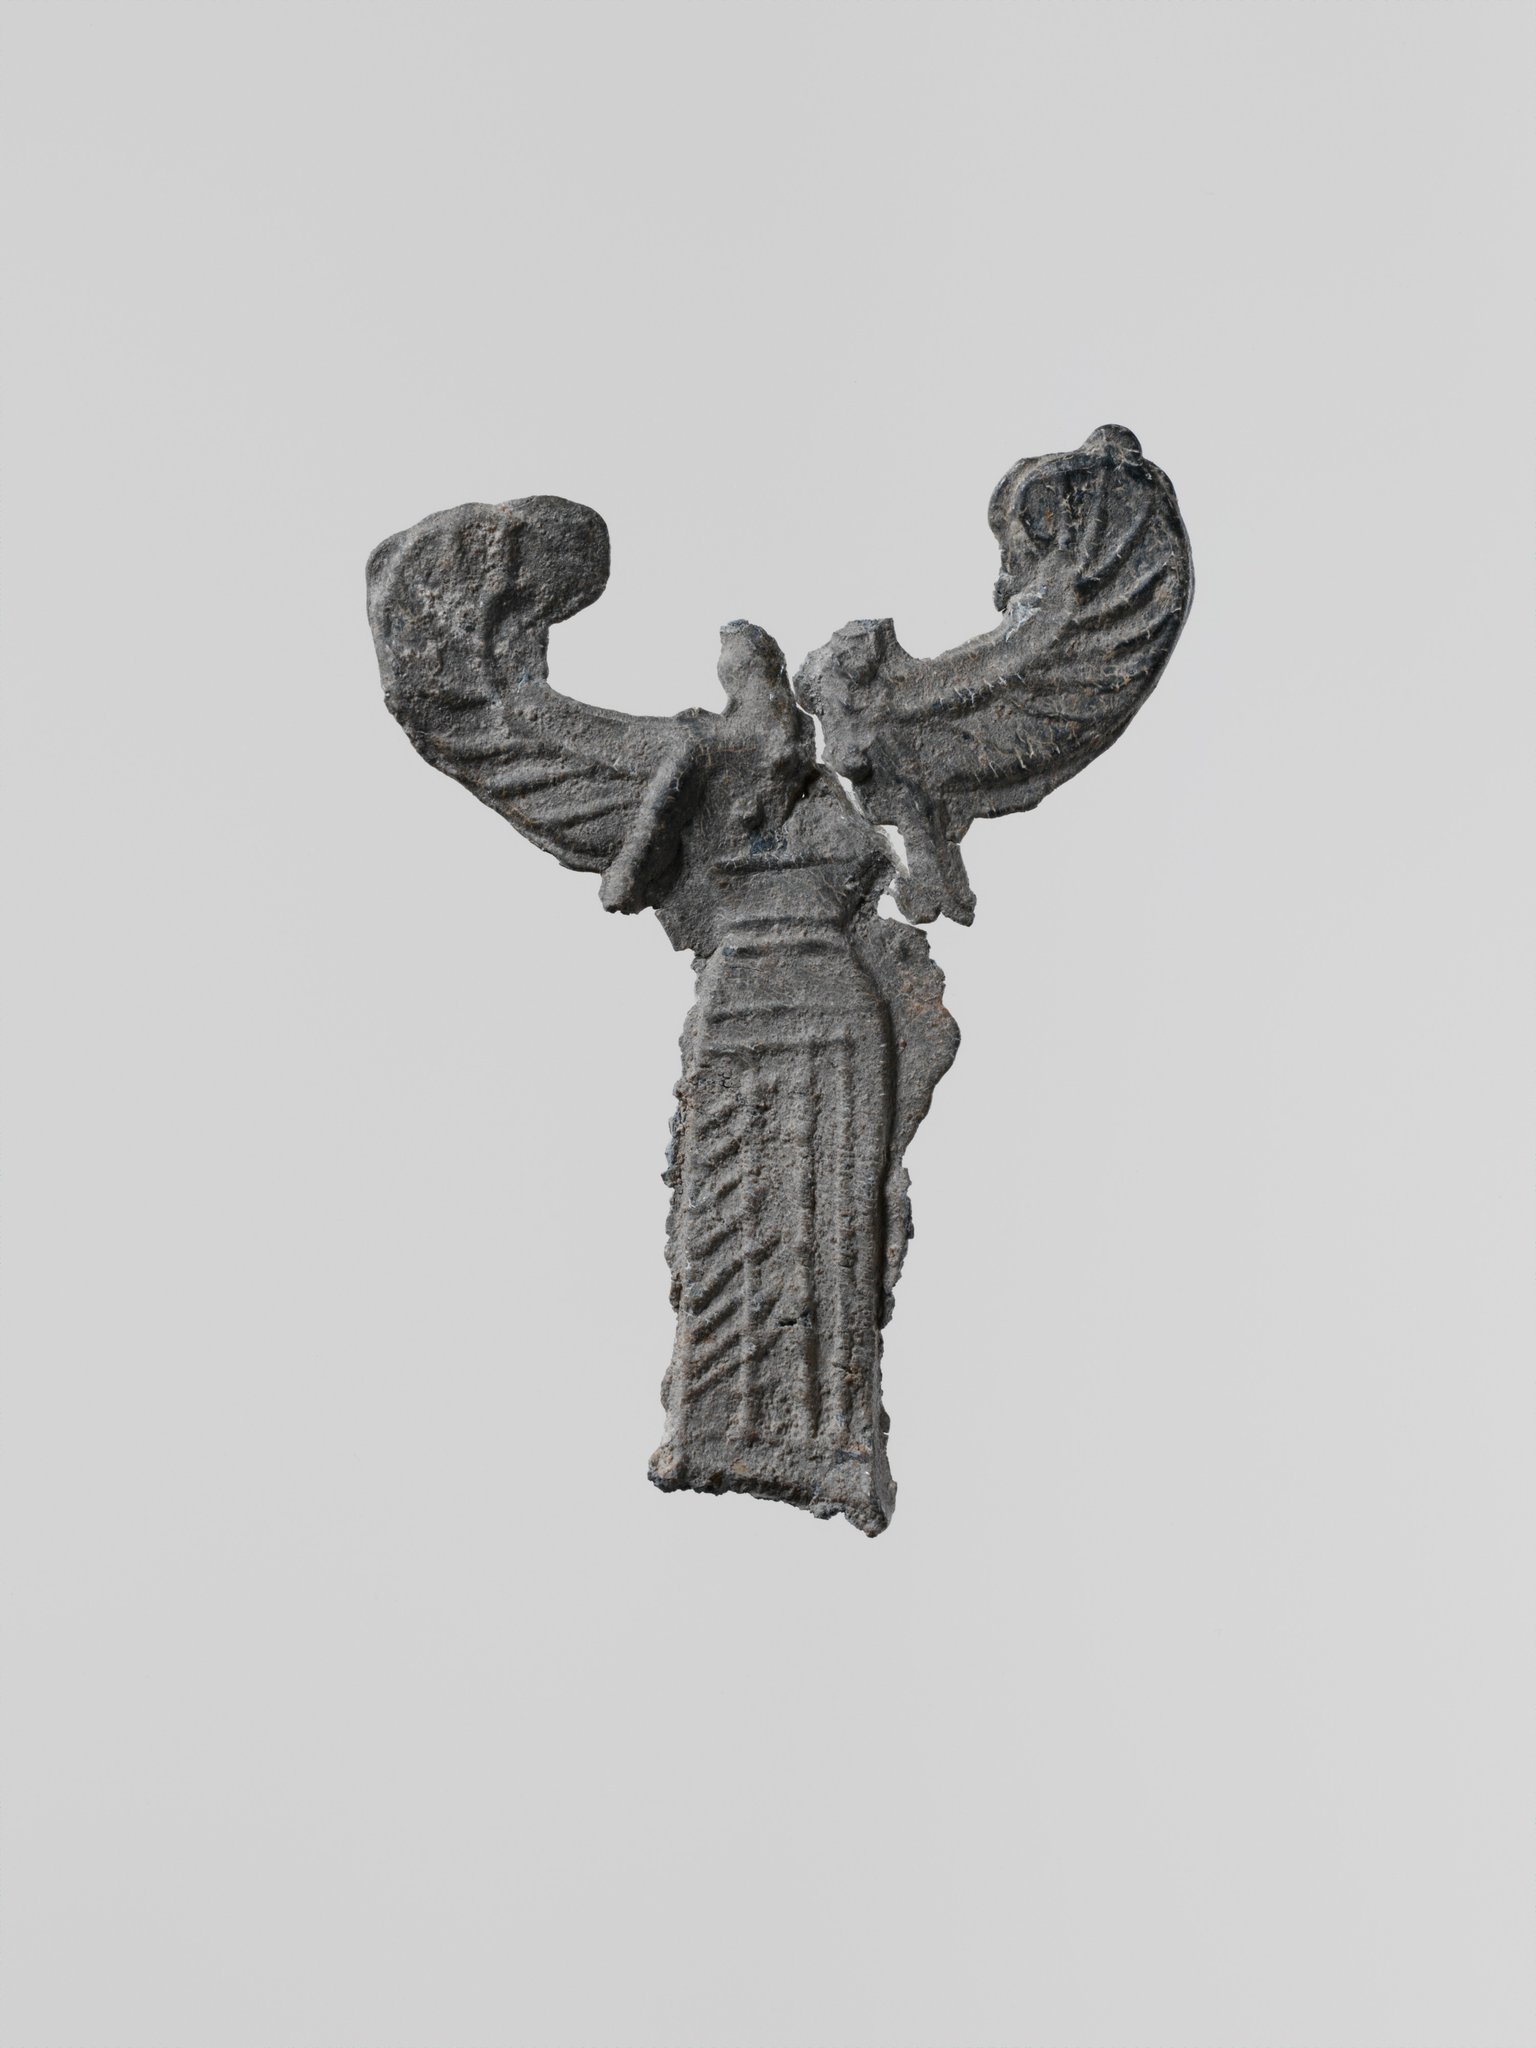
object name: statuette of artemis orthia winged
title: Lead figure of a winged goddess, possibly Artemis Orthia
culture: greek, laconian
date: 634-501 BCE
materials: lead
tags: artemis